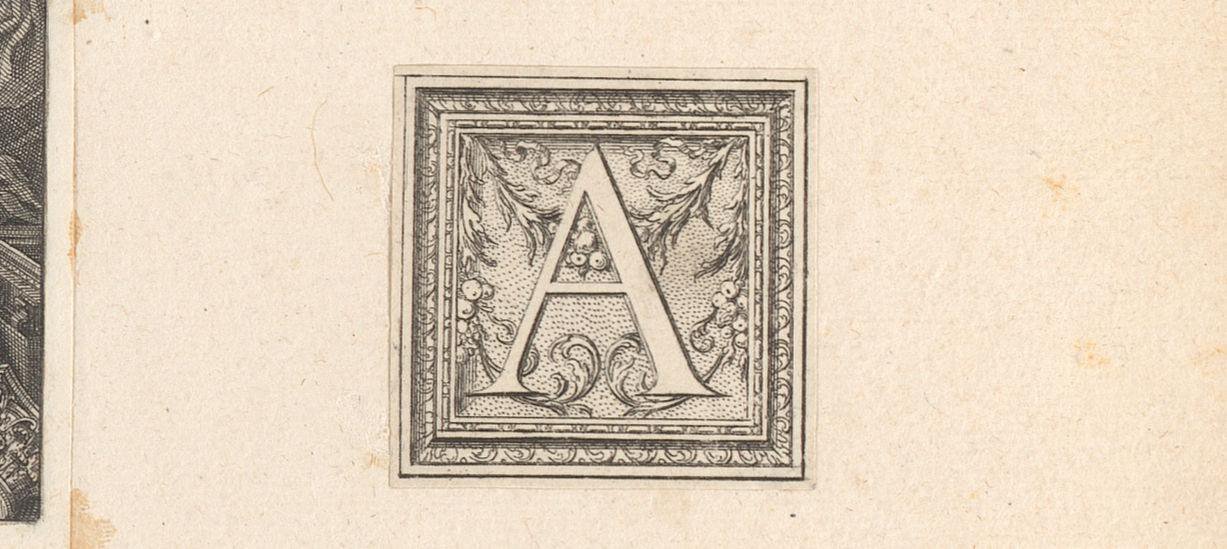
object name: album leaf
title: Initiaal 'A' met guirlandes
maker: sébastien leclerc (i)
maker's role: print maker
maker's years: 1637-1714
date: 1647-1714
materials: paper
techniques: etching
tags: initial, ornament ~ festoon, garland